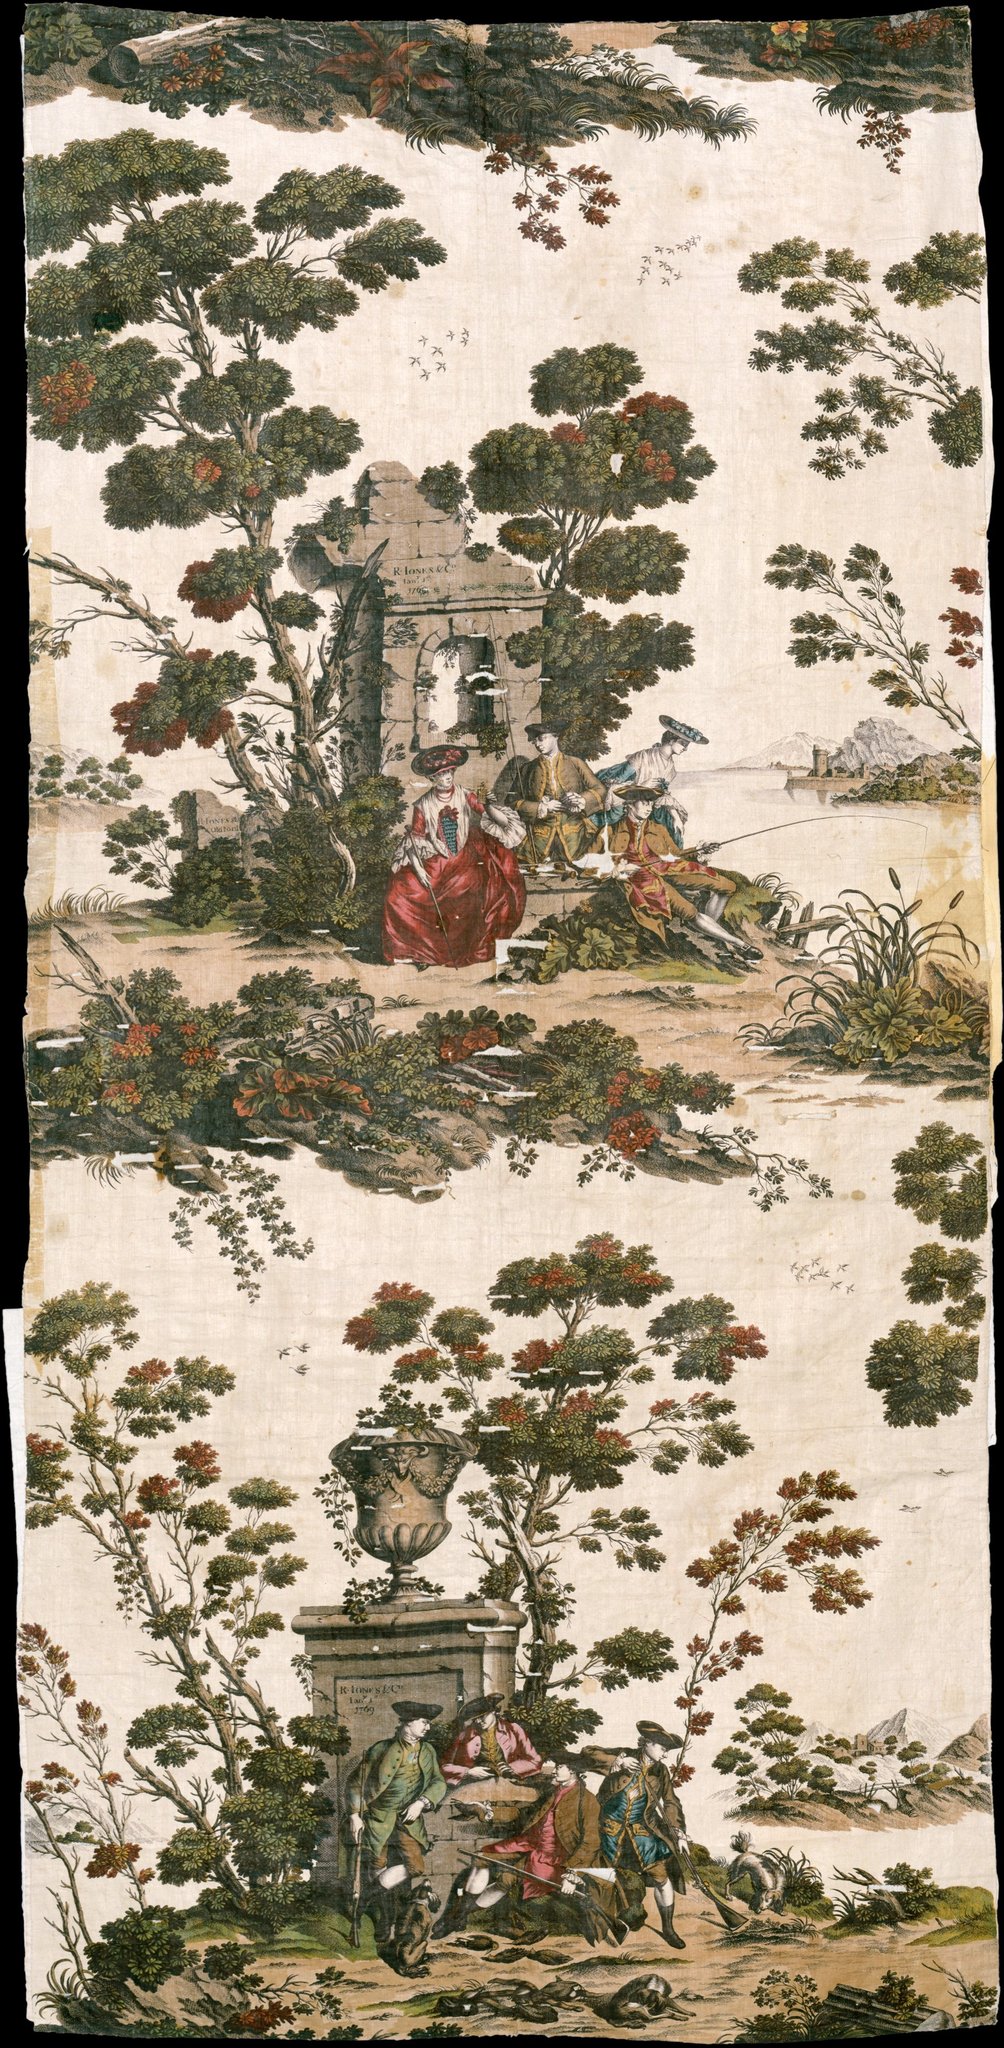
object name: length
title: Hunting and fishing scenes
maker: robert jones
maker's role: manufactory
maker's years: 1700-1800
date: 1769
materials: cotton, linen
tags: men,women,fishing,hunting